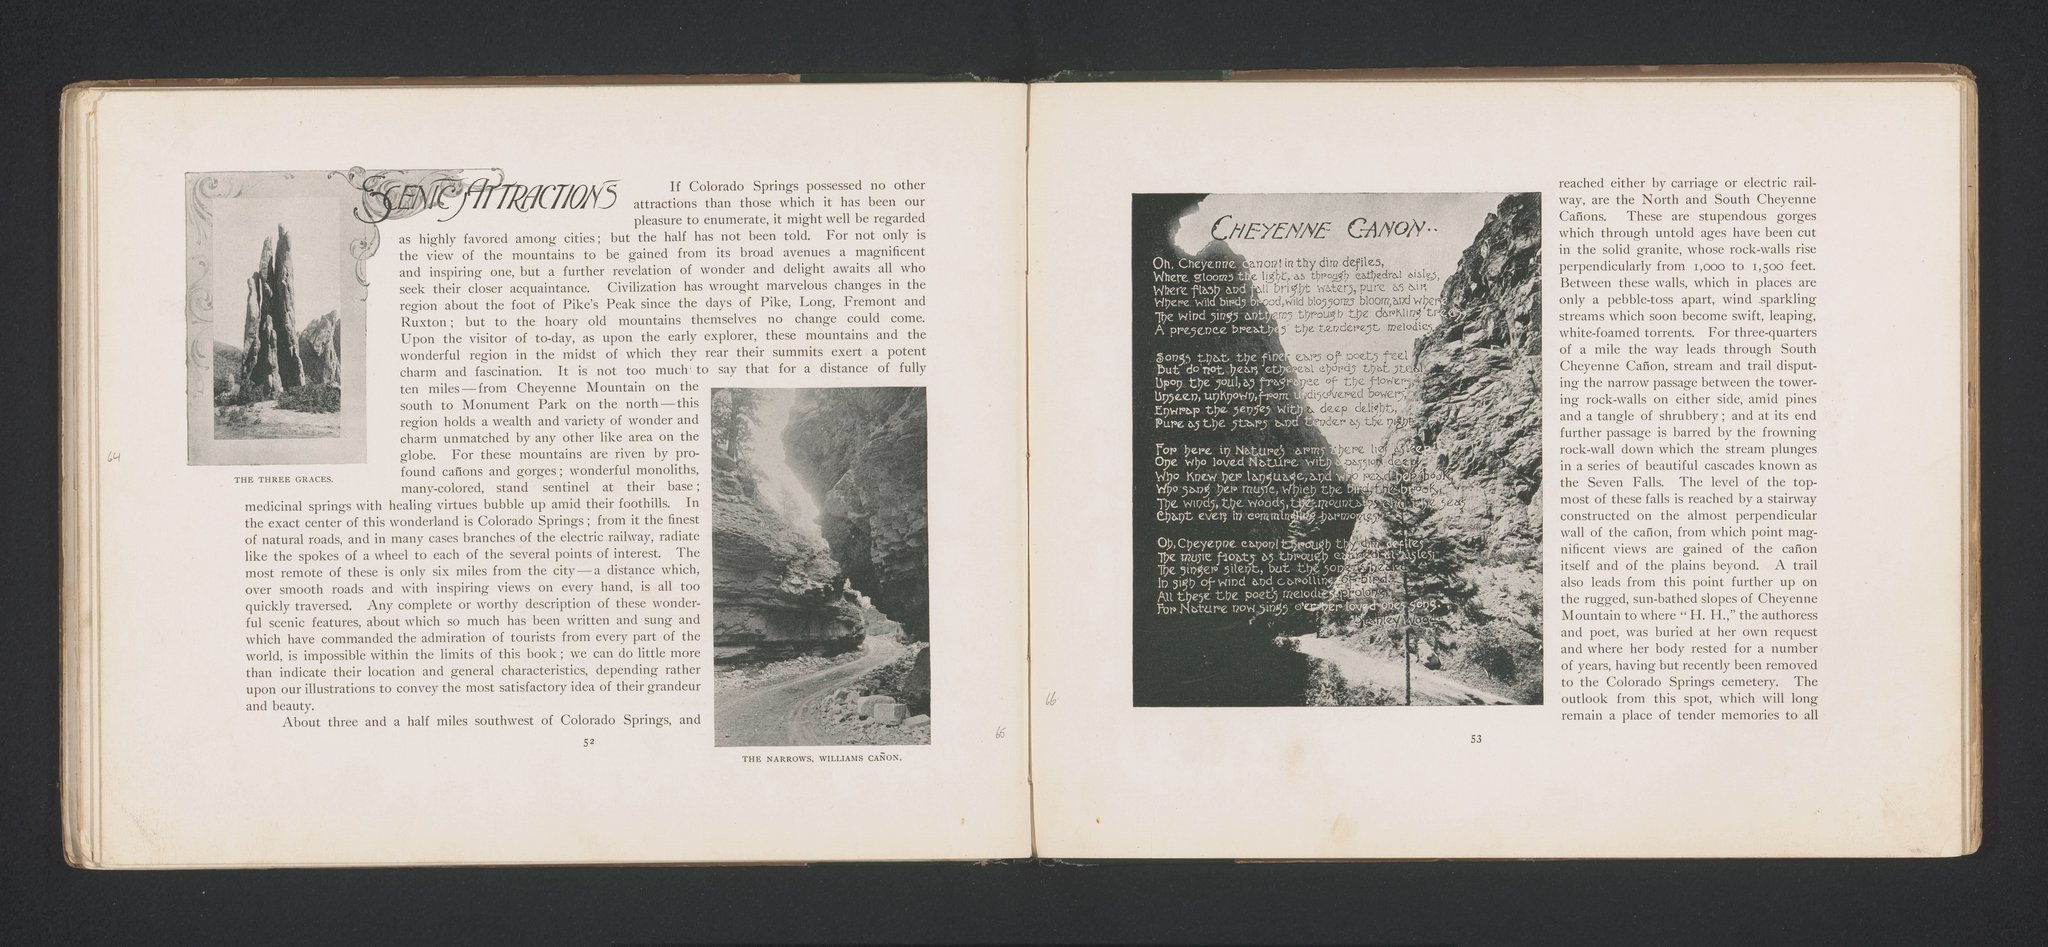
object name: photomechanical print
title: The three graces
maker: Anonymous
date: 1888-1893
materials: paper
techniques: autotype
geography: new york city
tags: rock-formations